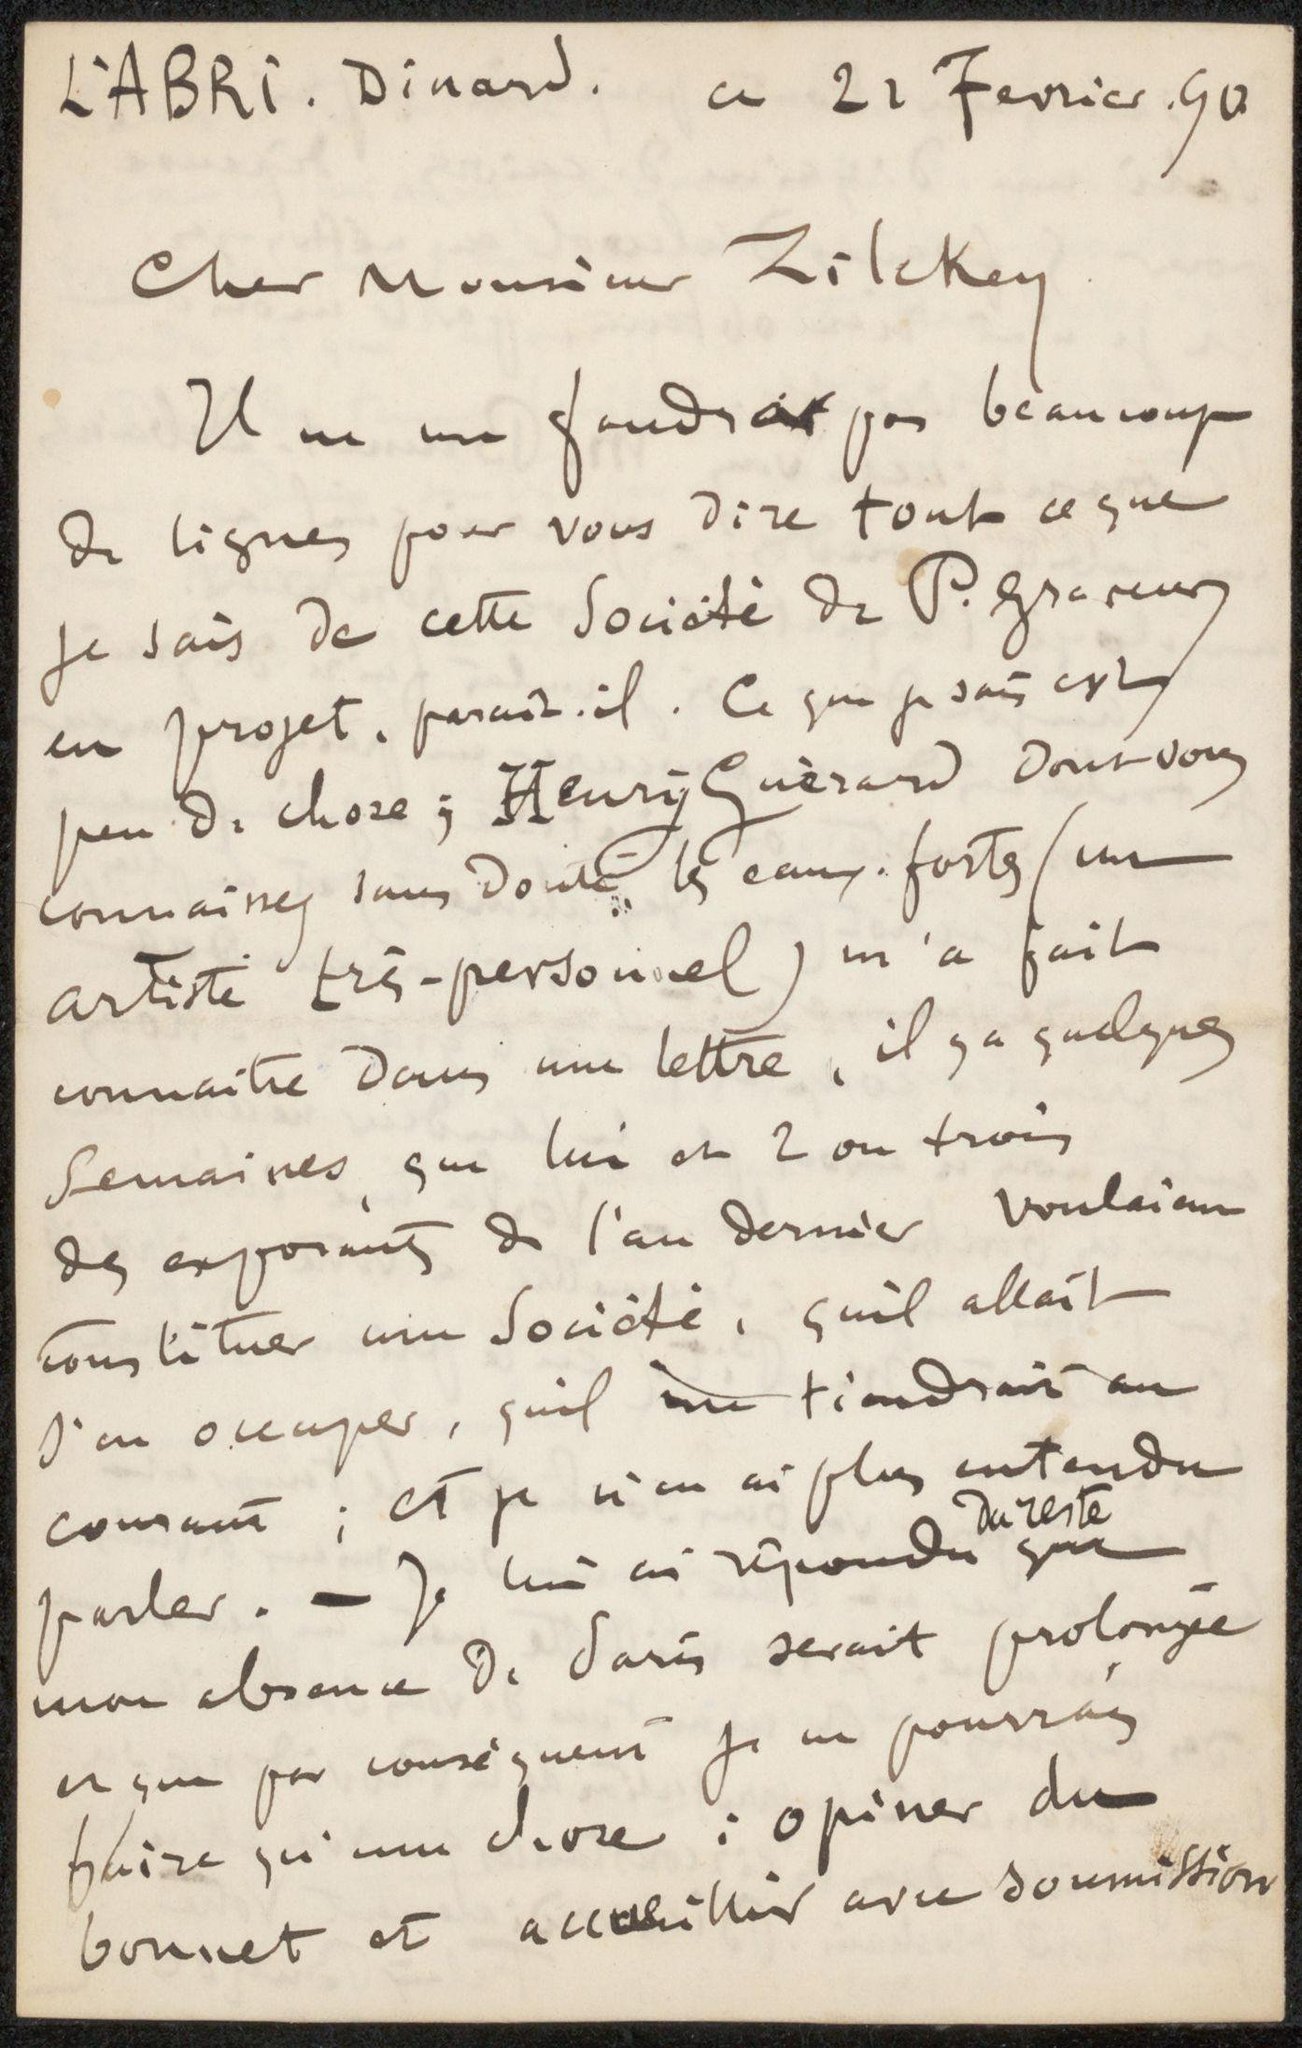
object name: letter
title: Brief aan Philip Zilcken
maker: félix hilaire buhot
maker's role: draughtsman, print maker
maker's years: 1847-1898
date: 1890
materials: ink, paper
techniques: pen, writing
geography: dinard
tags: le havre, alfred louis brunet-debaines, adriaan pit, henri charles guérard, the hague, painter, draughtsman, philip zilcken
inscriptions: collector's mark: ‘RPK’